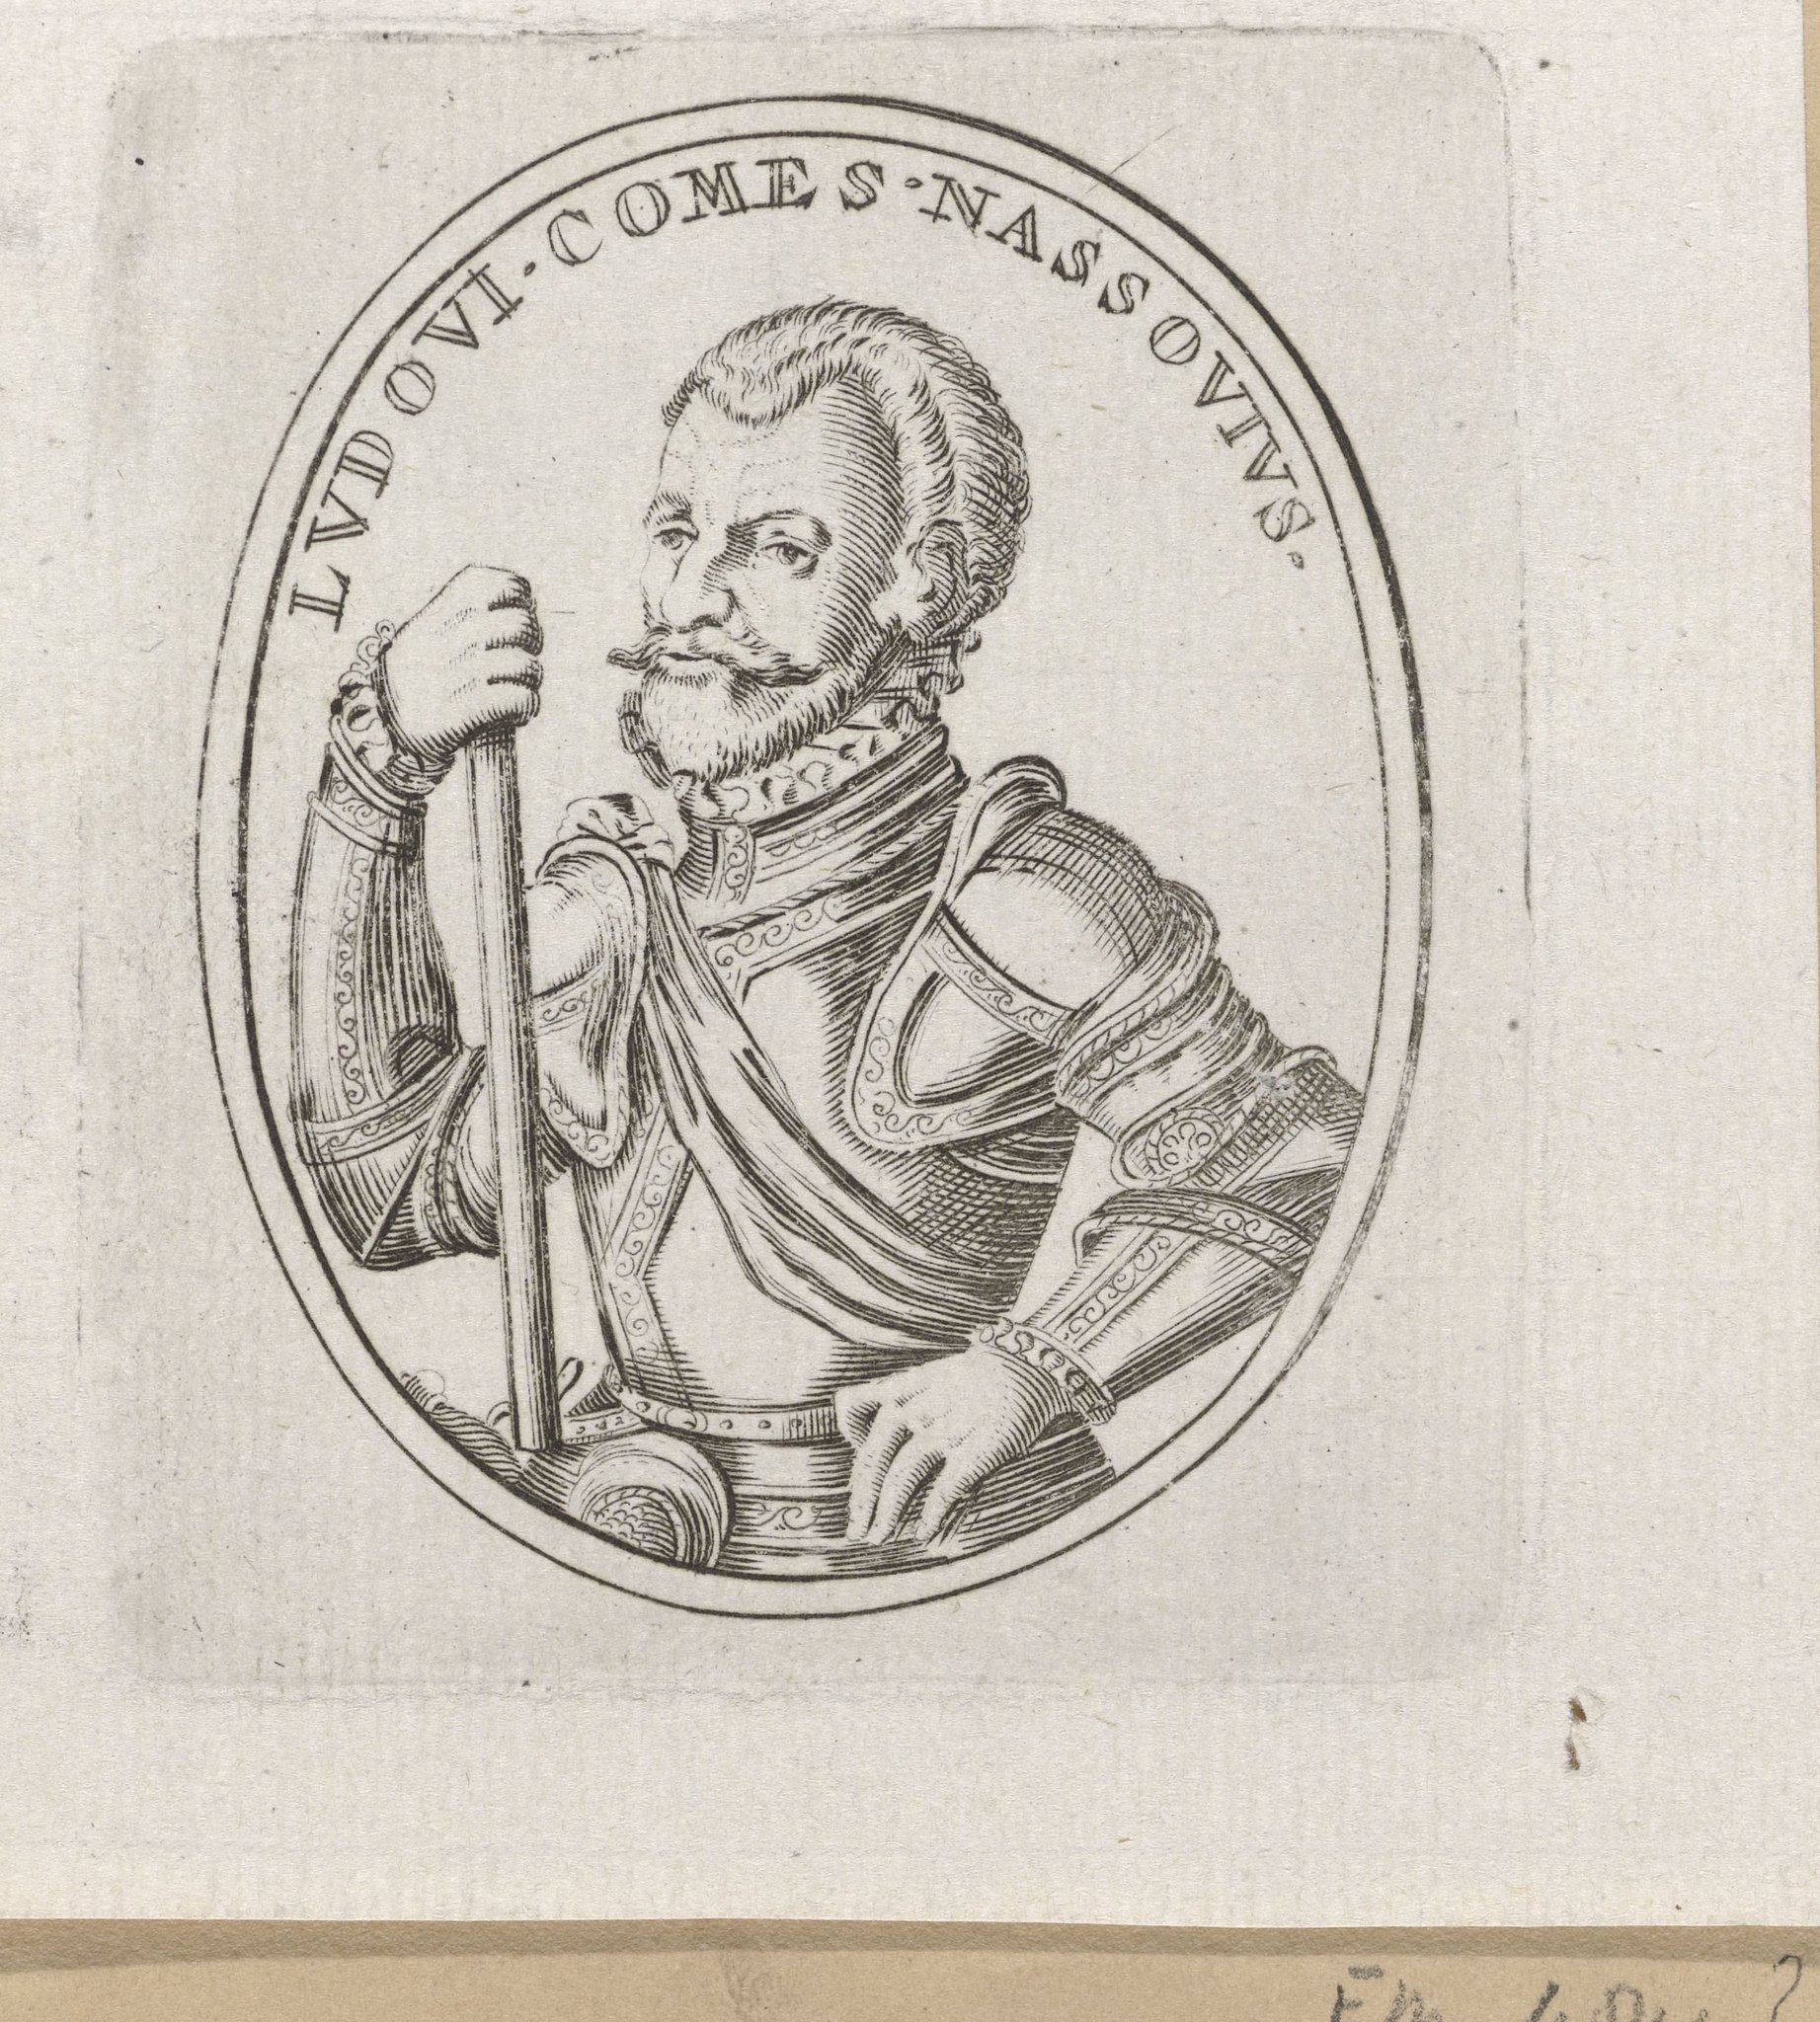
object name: print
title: Portret van Lodewijk, graaf van Nassau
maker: Anonymous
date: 1600-1699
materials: paper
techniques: engraving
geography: low countries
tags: dillenburg, lodewijk graaf van nassau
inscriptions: collector's mark: Lugt 963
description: De hier vermelde titel verwijst naar de hoogst verkregen titel van de geportretteerde, niet per se naar de titel die de geportretteerde op deze voorstelling draagt.